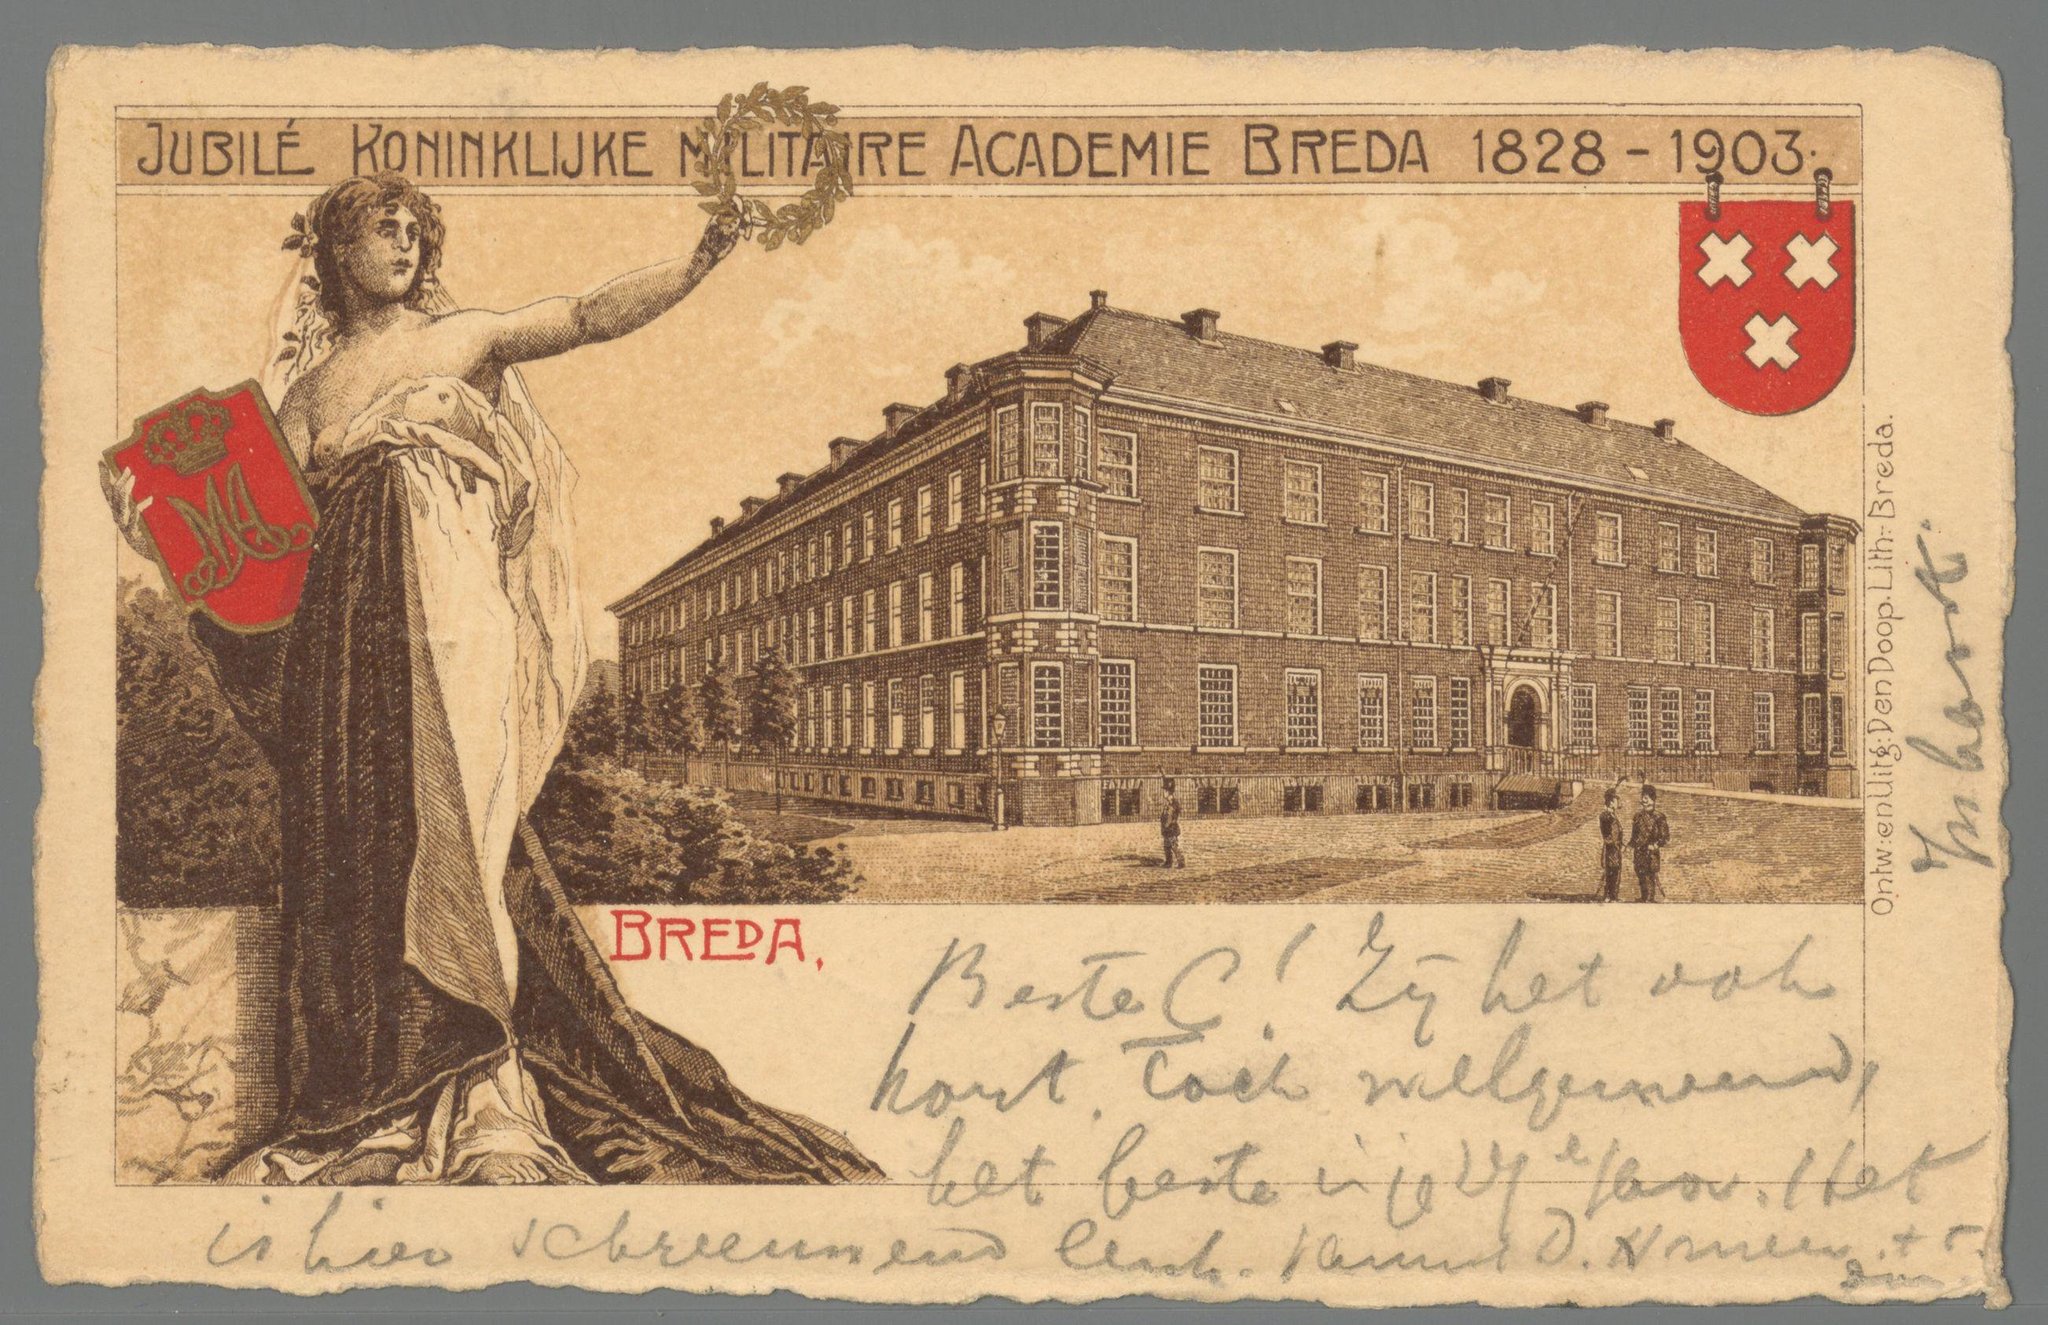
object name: photomechanical print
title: Jubilé Koninklijke Militaire Academie Breda 1828-1903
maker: adriaan wouter den doop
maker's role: print maker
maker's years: 1855-1912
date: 1903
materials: cardboard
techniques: hand coloring, printing block, writing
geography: breda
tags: coat of arms (as symbol of the state, etc.), garland, wreath, personification of a city, town-patron(ess), military academy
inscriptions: postage stamp